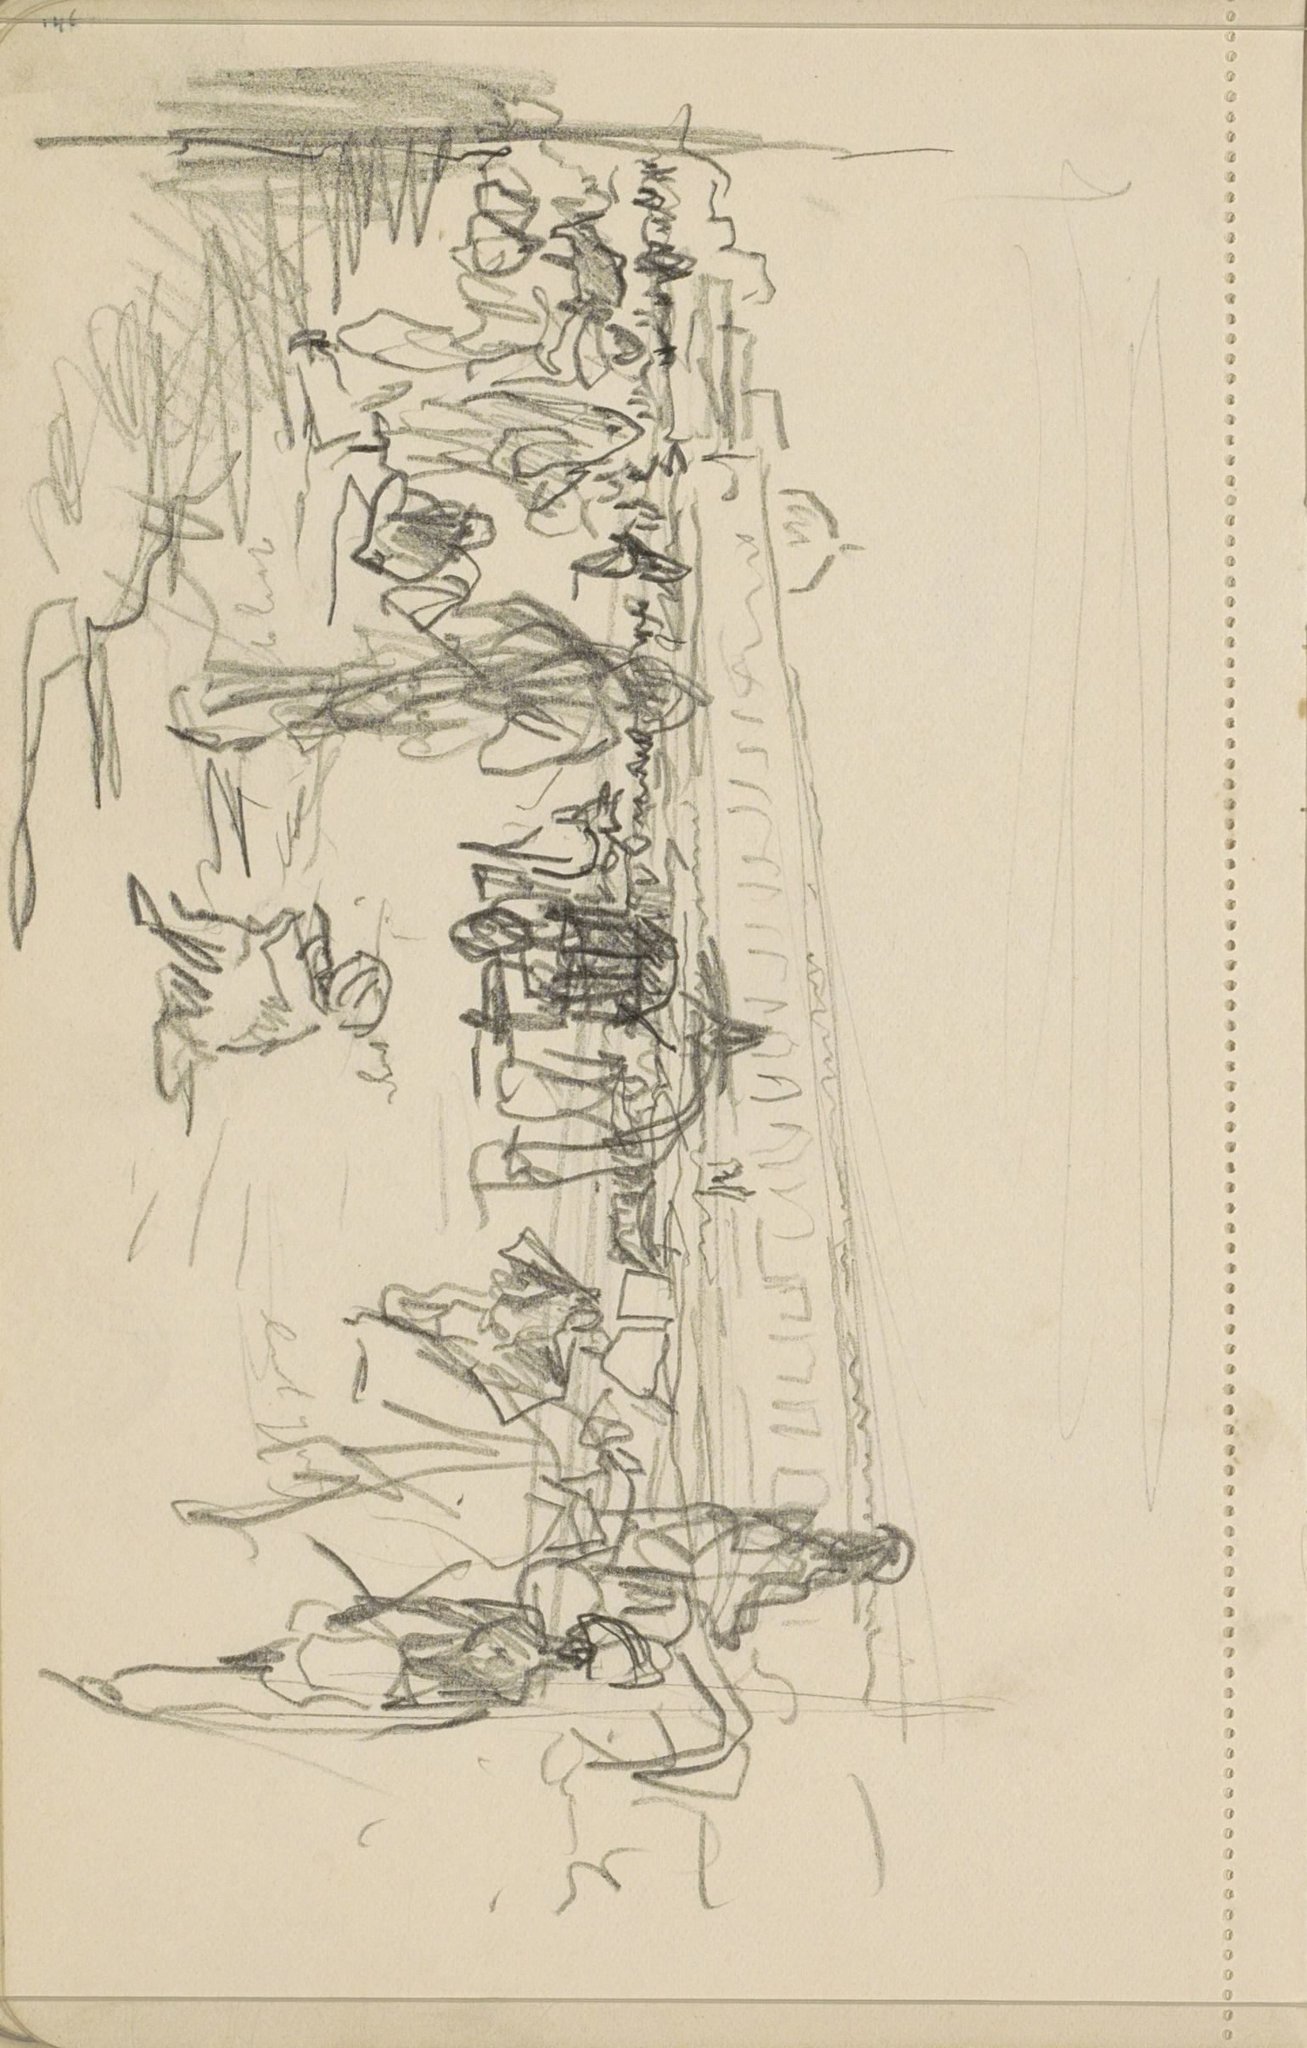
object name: sketchbook leaf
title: Straatscène in India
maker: marius bauer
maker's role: draughtsman, print maker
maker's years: 1867-1932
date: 1924-1925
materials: paper, pencil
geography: india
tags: asiatic races and peoples: indians, (farm) wagon, freight wagon, cart, street (+ city(-scape) with figures, staffage)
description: Op de voorgrond Indiërs en karren. Pagina 146 uit een schetsboek met 87 bladen.